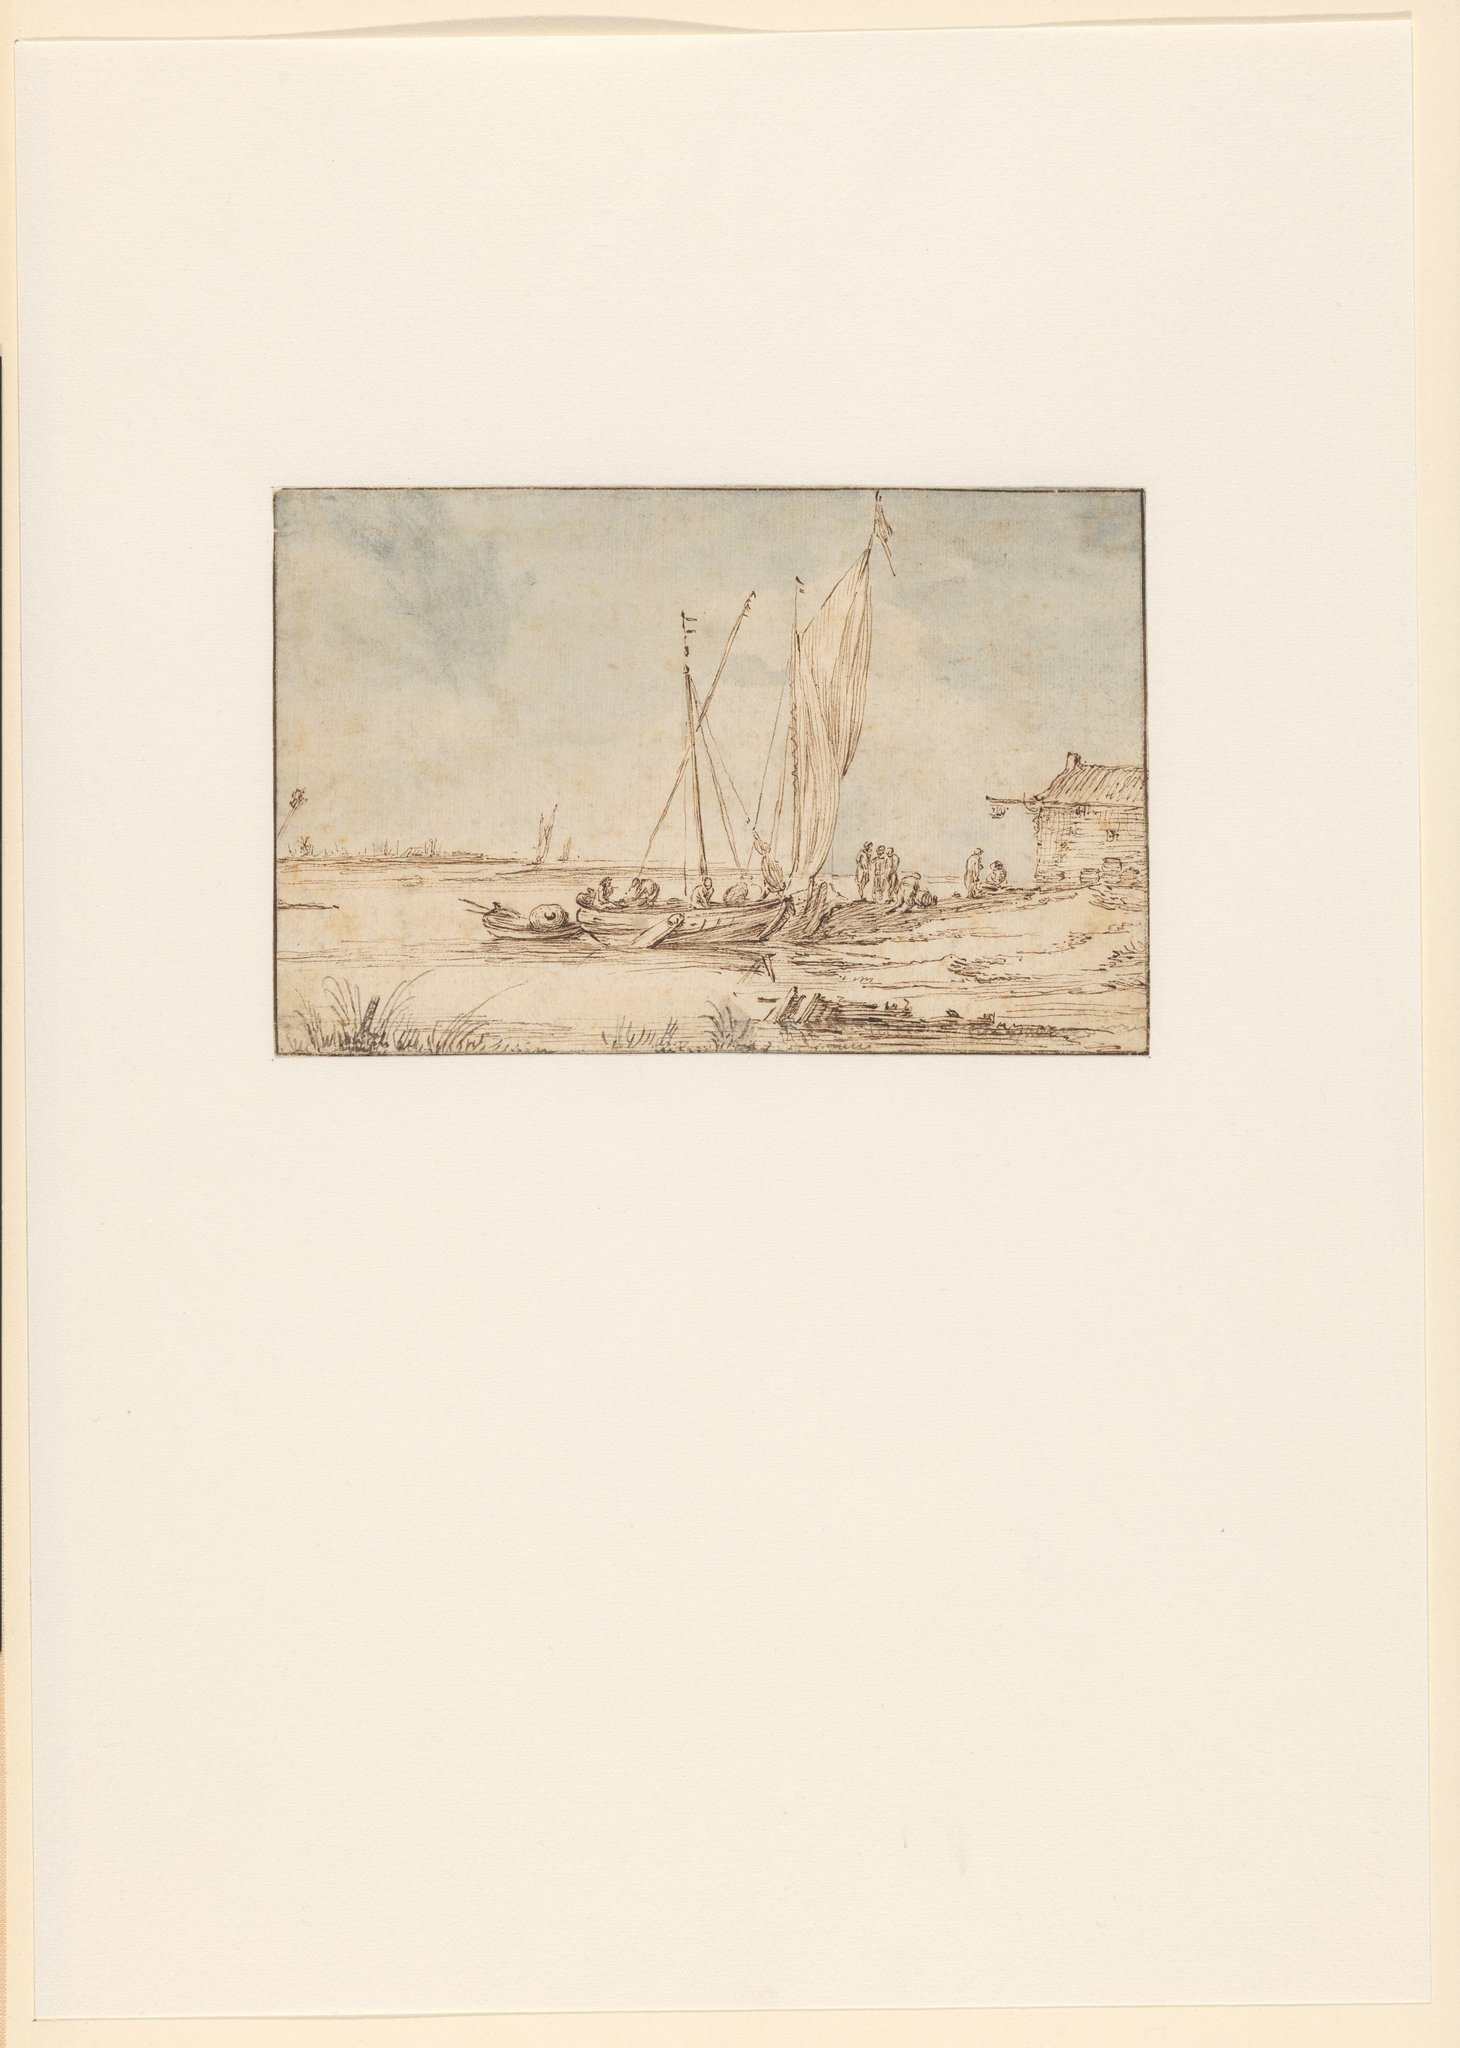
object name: drawing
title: Riviergezicht met een boot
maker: nicolaes van lijnhoven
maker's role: draughtsman, print maker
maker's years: -1702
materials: ink, paper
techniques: brush, pen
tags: sailing-ship, sailing-boat, river bank, hotel, hostelry, inn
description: Riviergezicht met een boot die aanlegt bij een herberg.